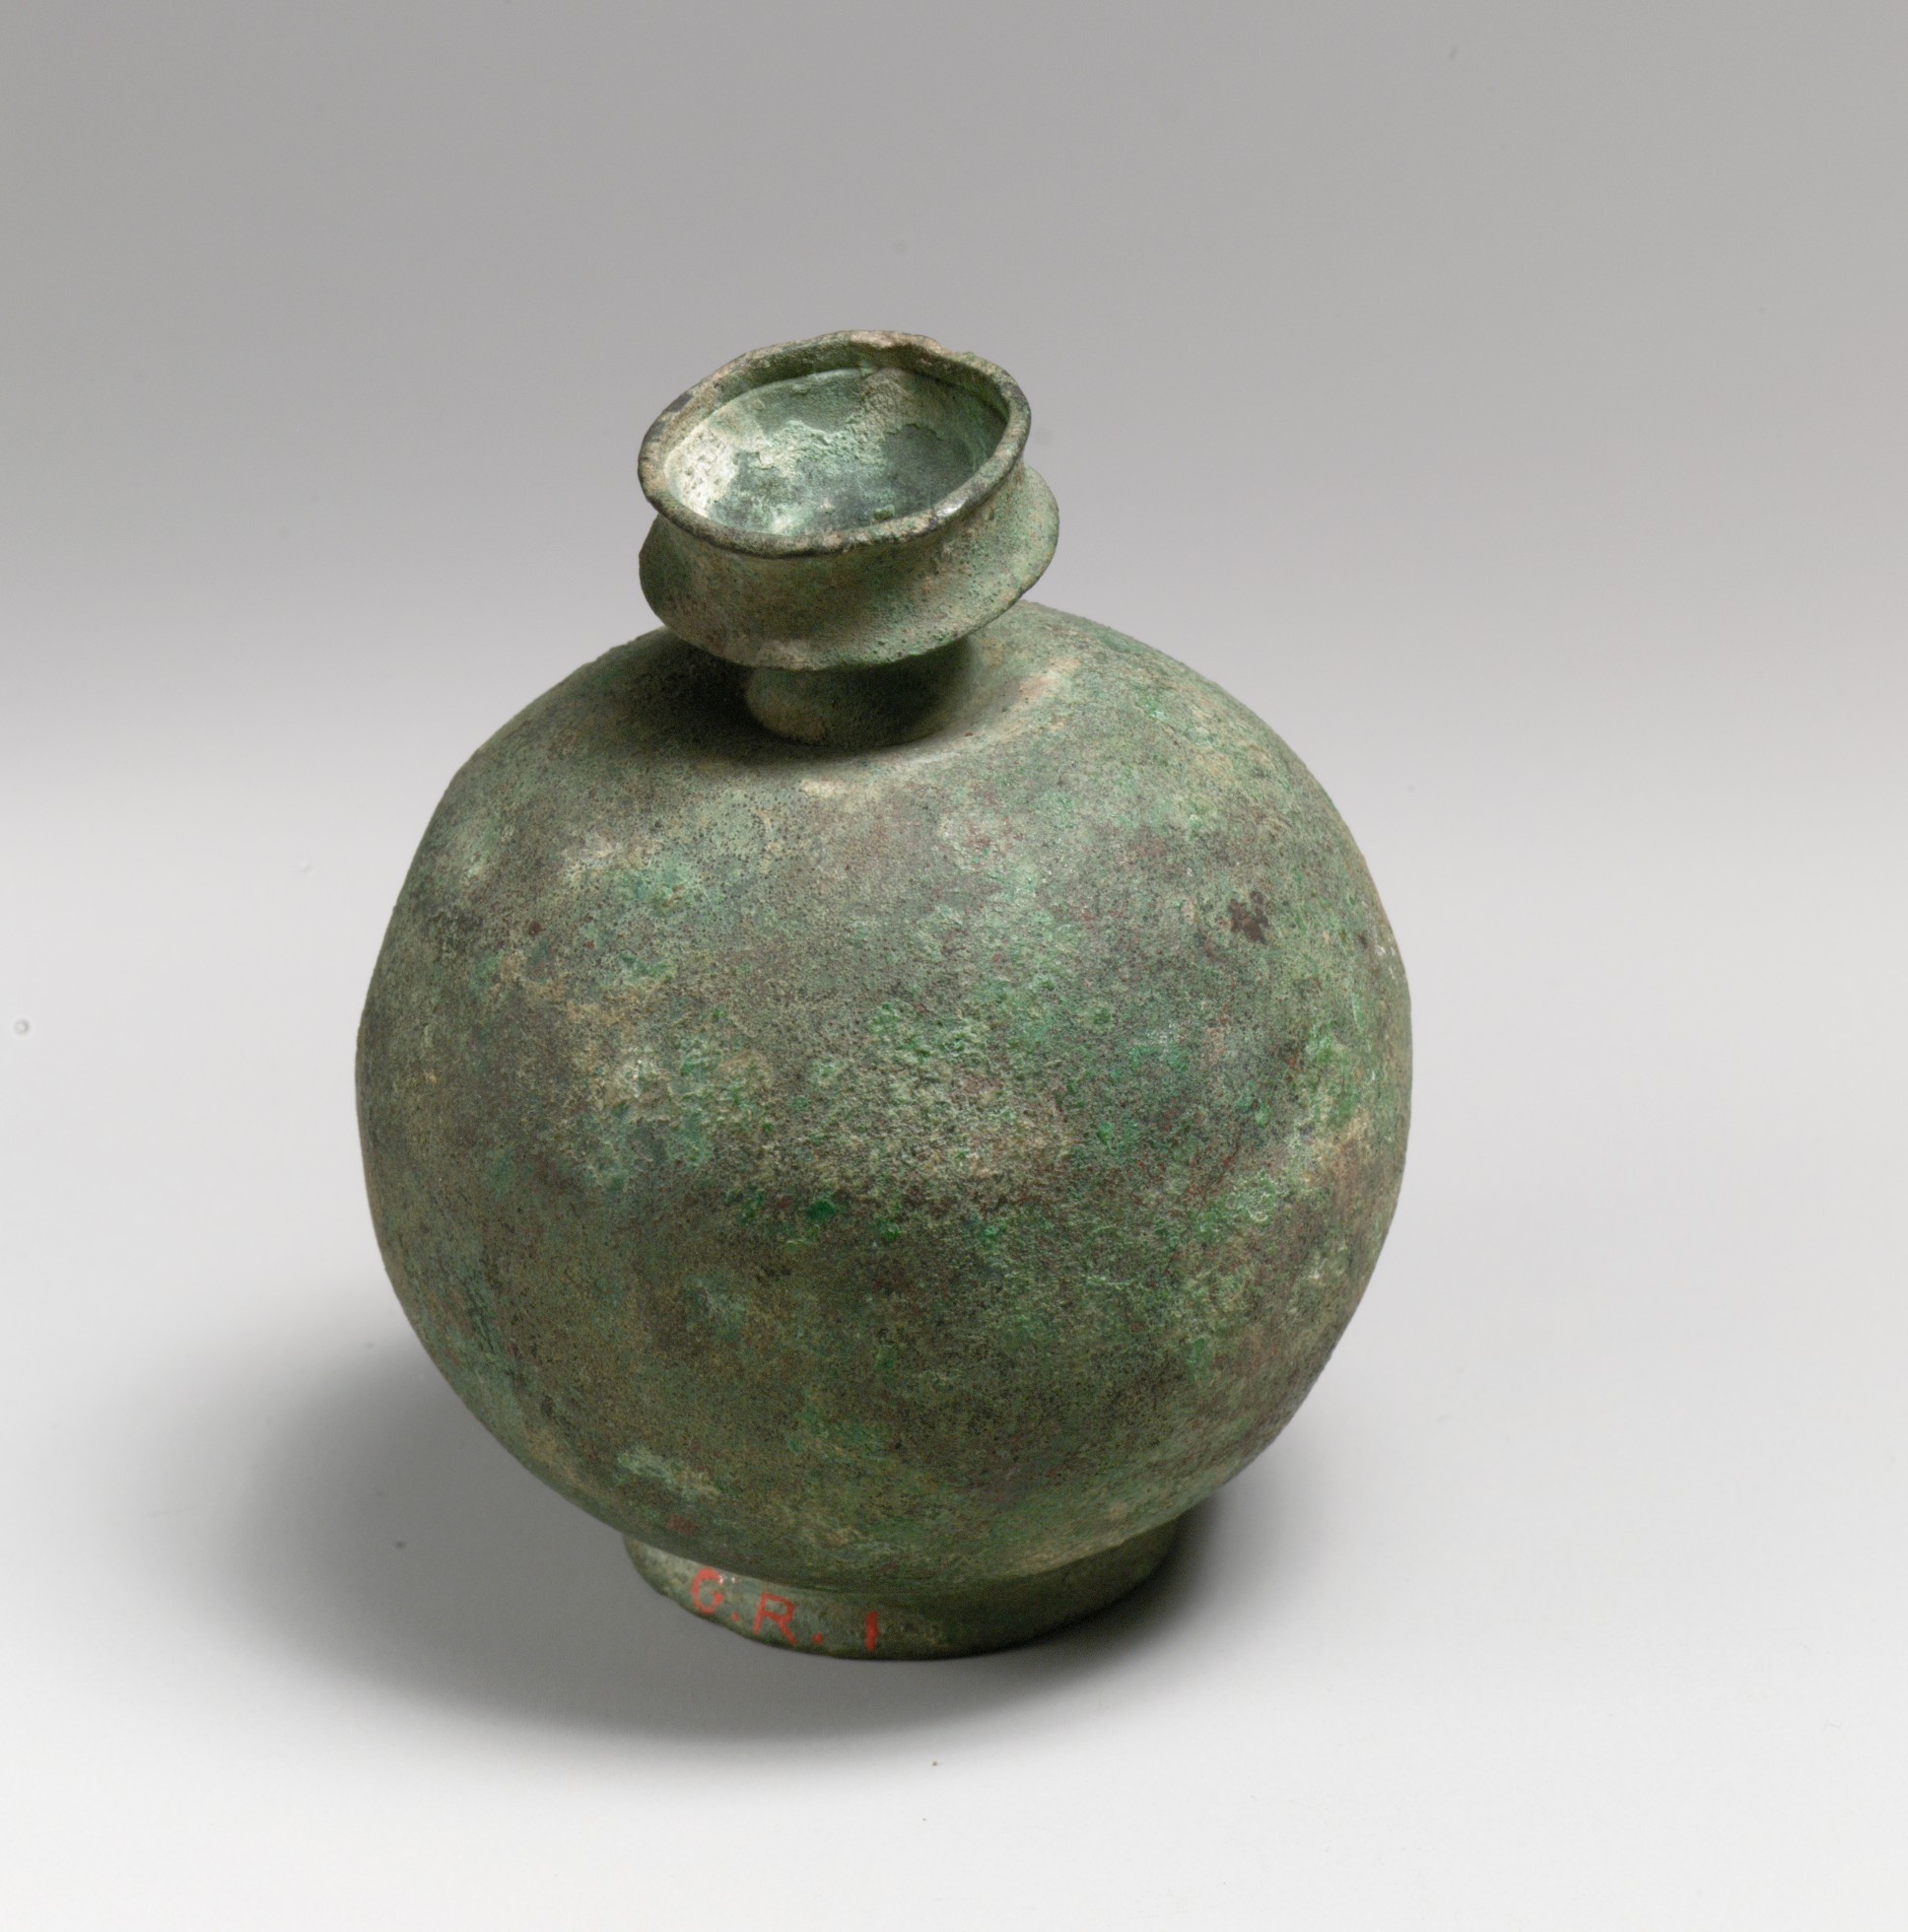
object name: bottle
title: Bronze aryballos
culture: roman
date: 1-200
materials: bronze